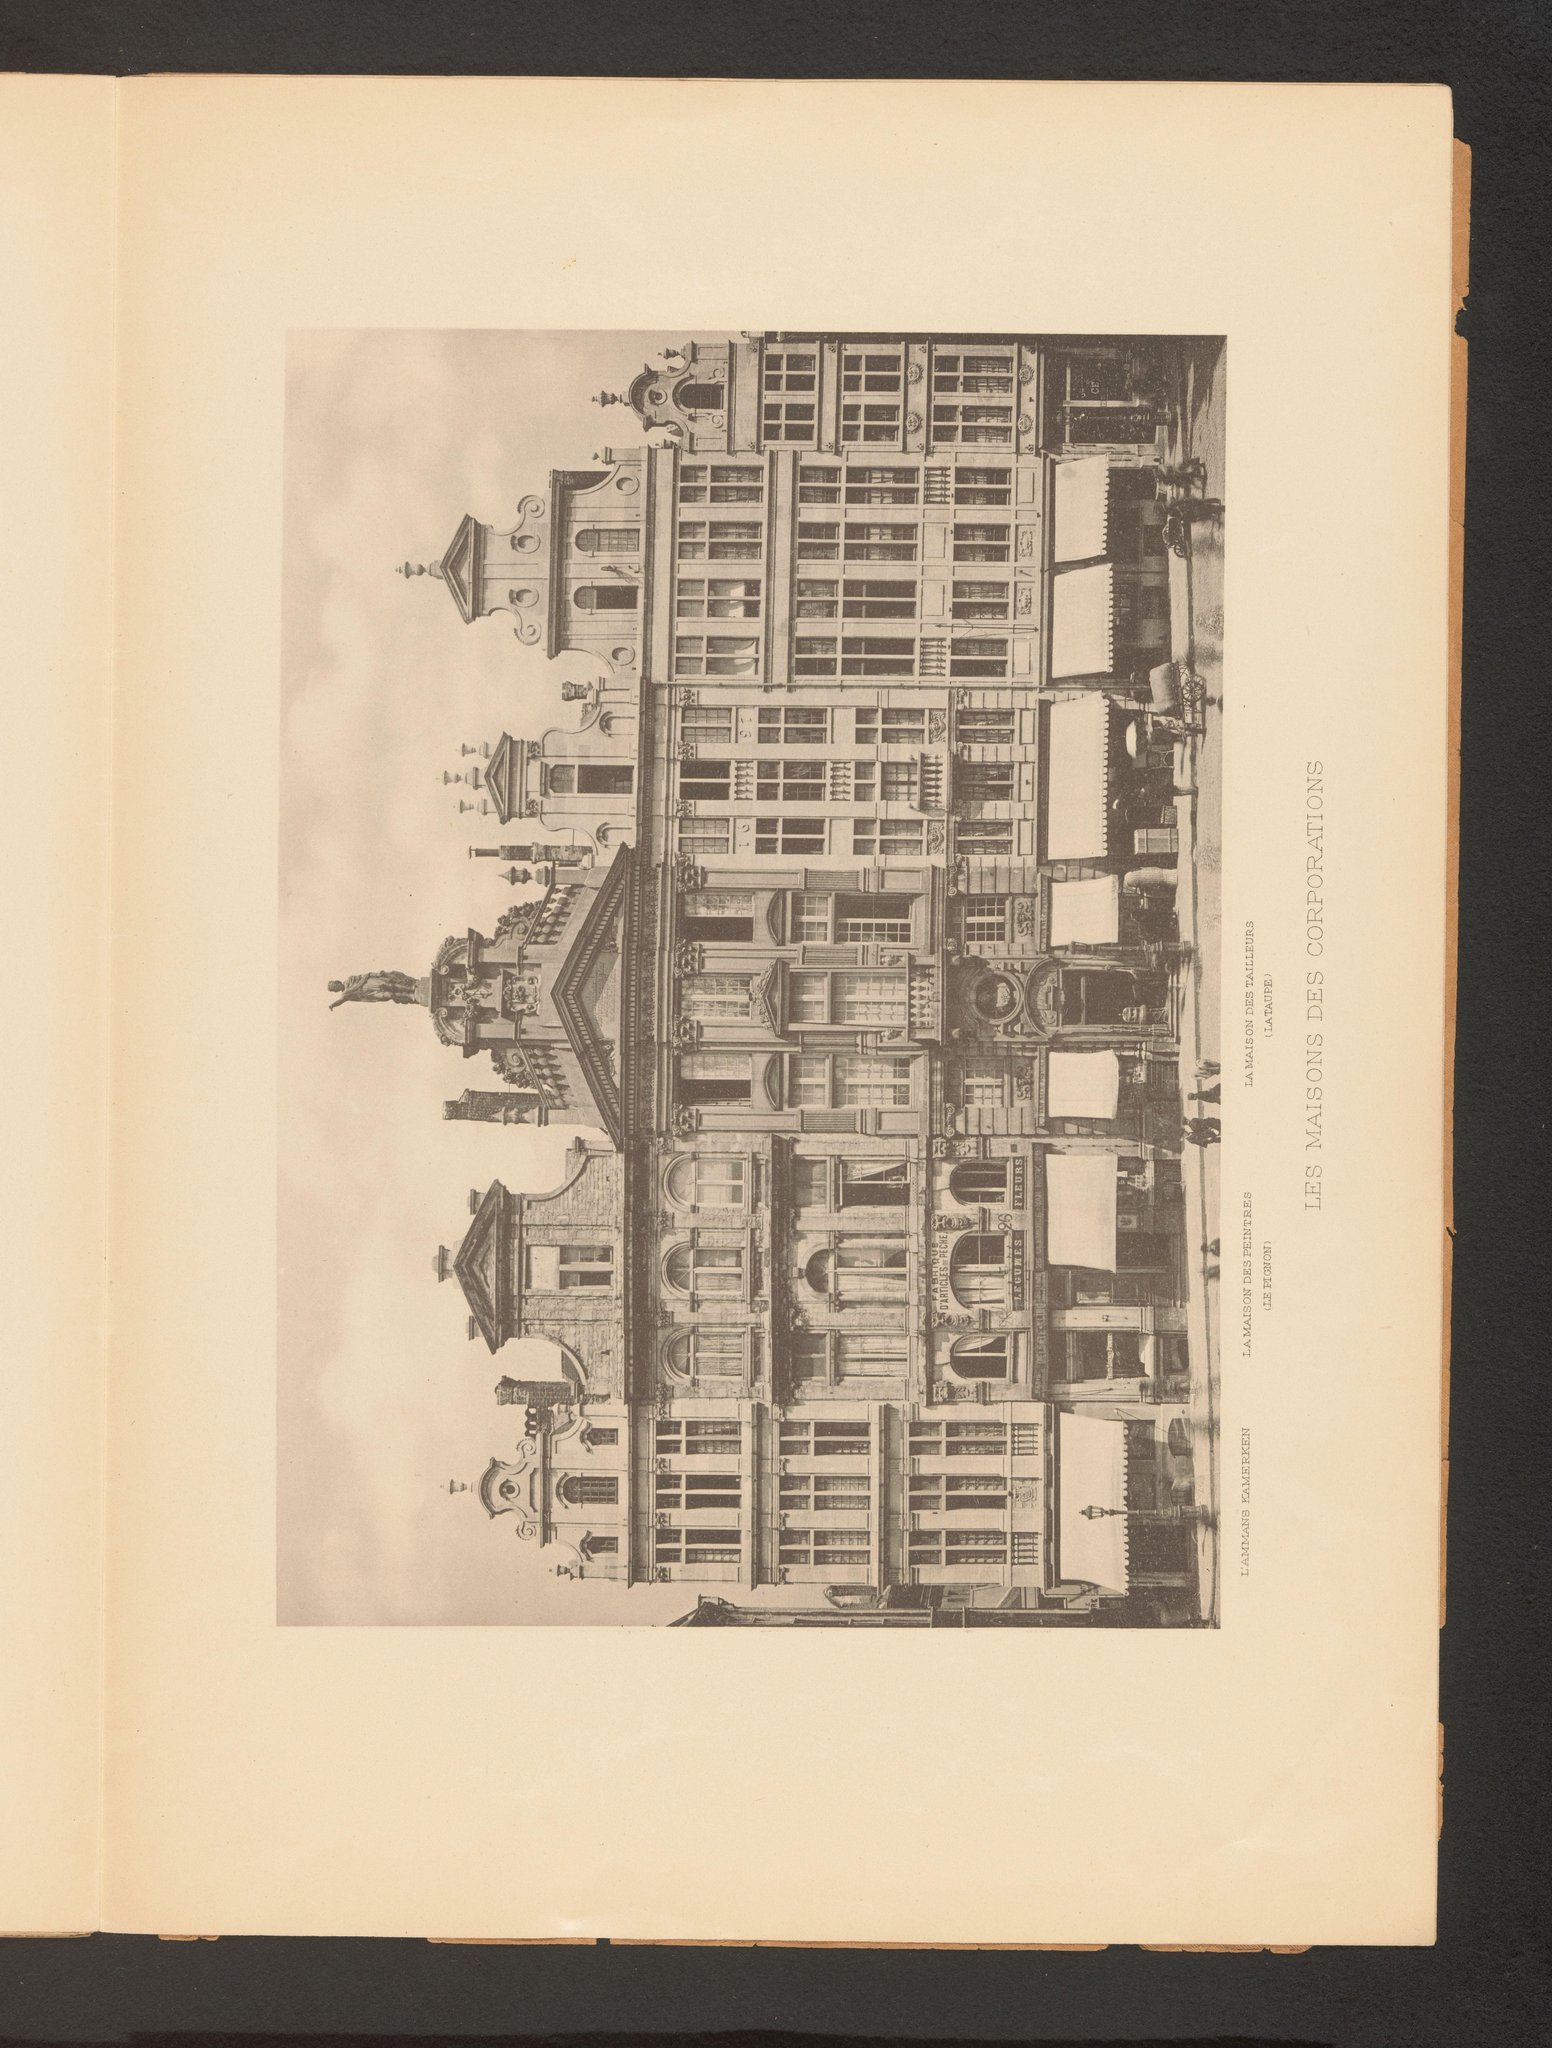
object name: photomechanical print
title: Gezicht op de Gildehuizen aan de Grote Markt in Brussel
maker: Anonymous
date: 1894-1899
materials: paper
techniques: photograph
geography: brussels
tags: corporative organization, guild, civic architecture; edifices; dwellings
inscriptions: inscription: ‘L'Ammans Kamerken, La Maison des Peintres/ (Le Pignon), La Maison des Tailleurs/ (La Taupe)’